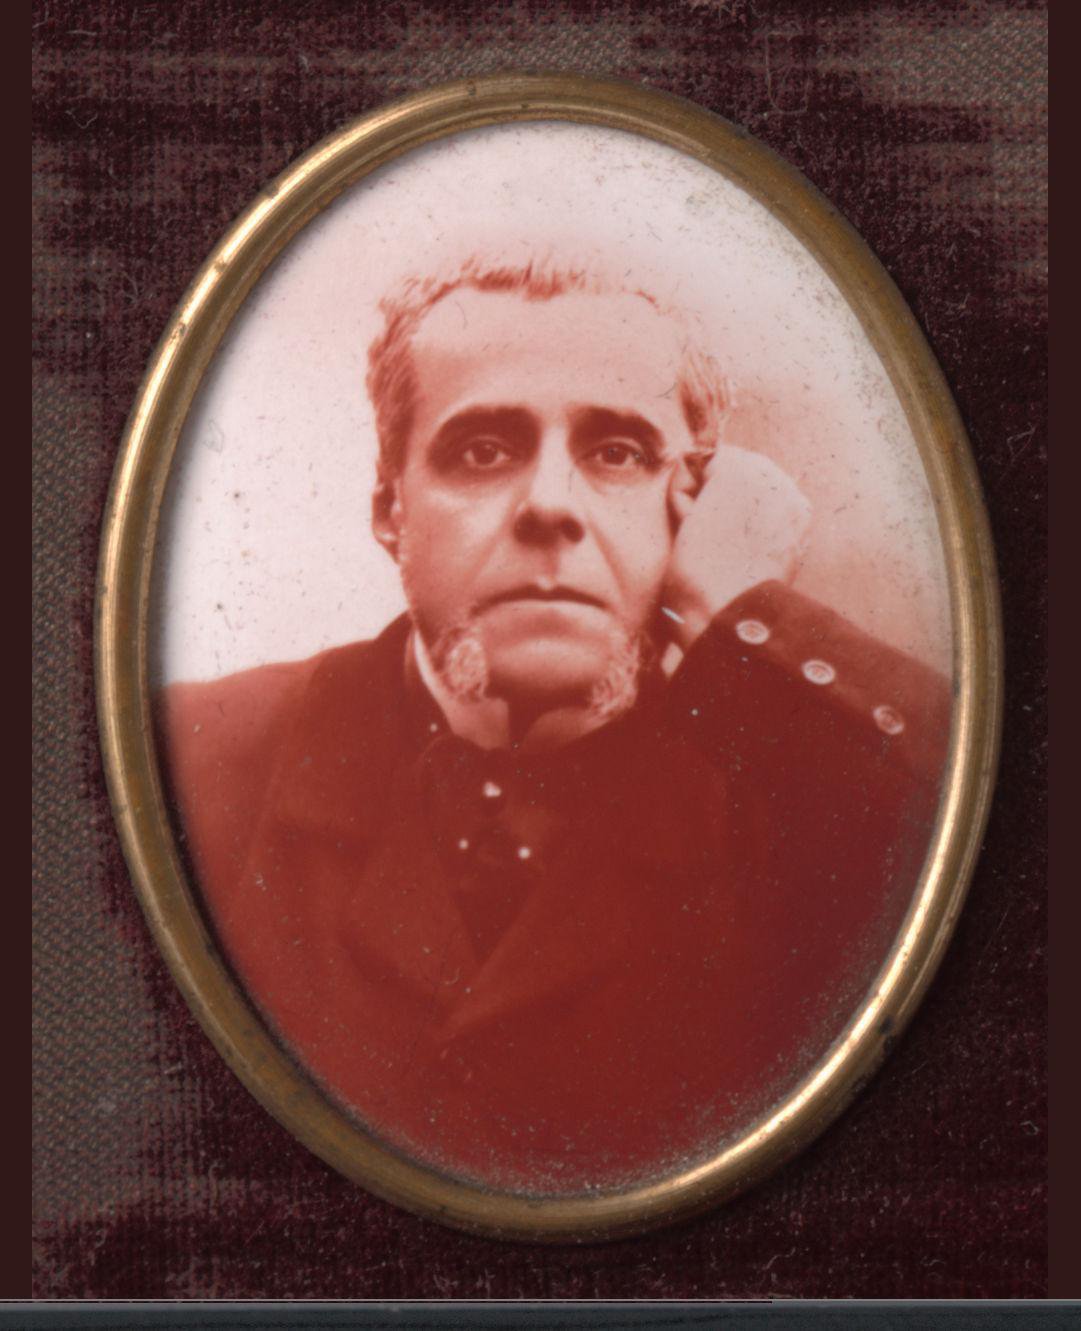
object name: photograph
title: Portret van een onbekende man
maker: Anonymous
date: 1880-1900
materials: leather, metal, textile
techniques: photoceramics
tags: historical persons